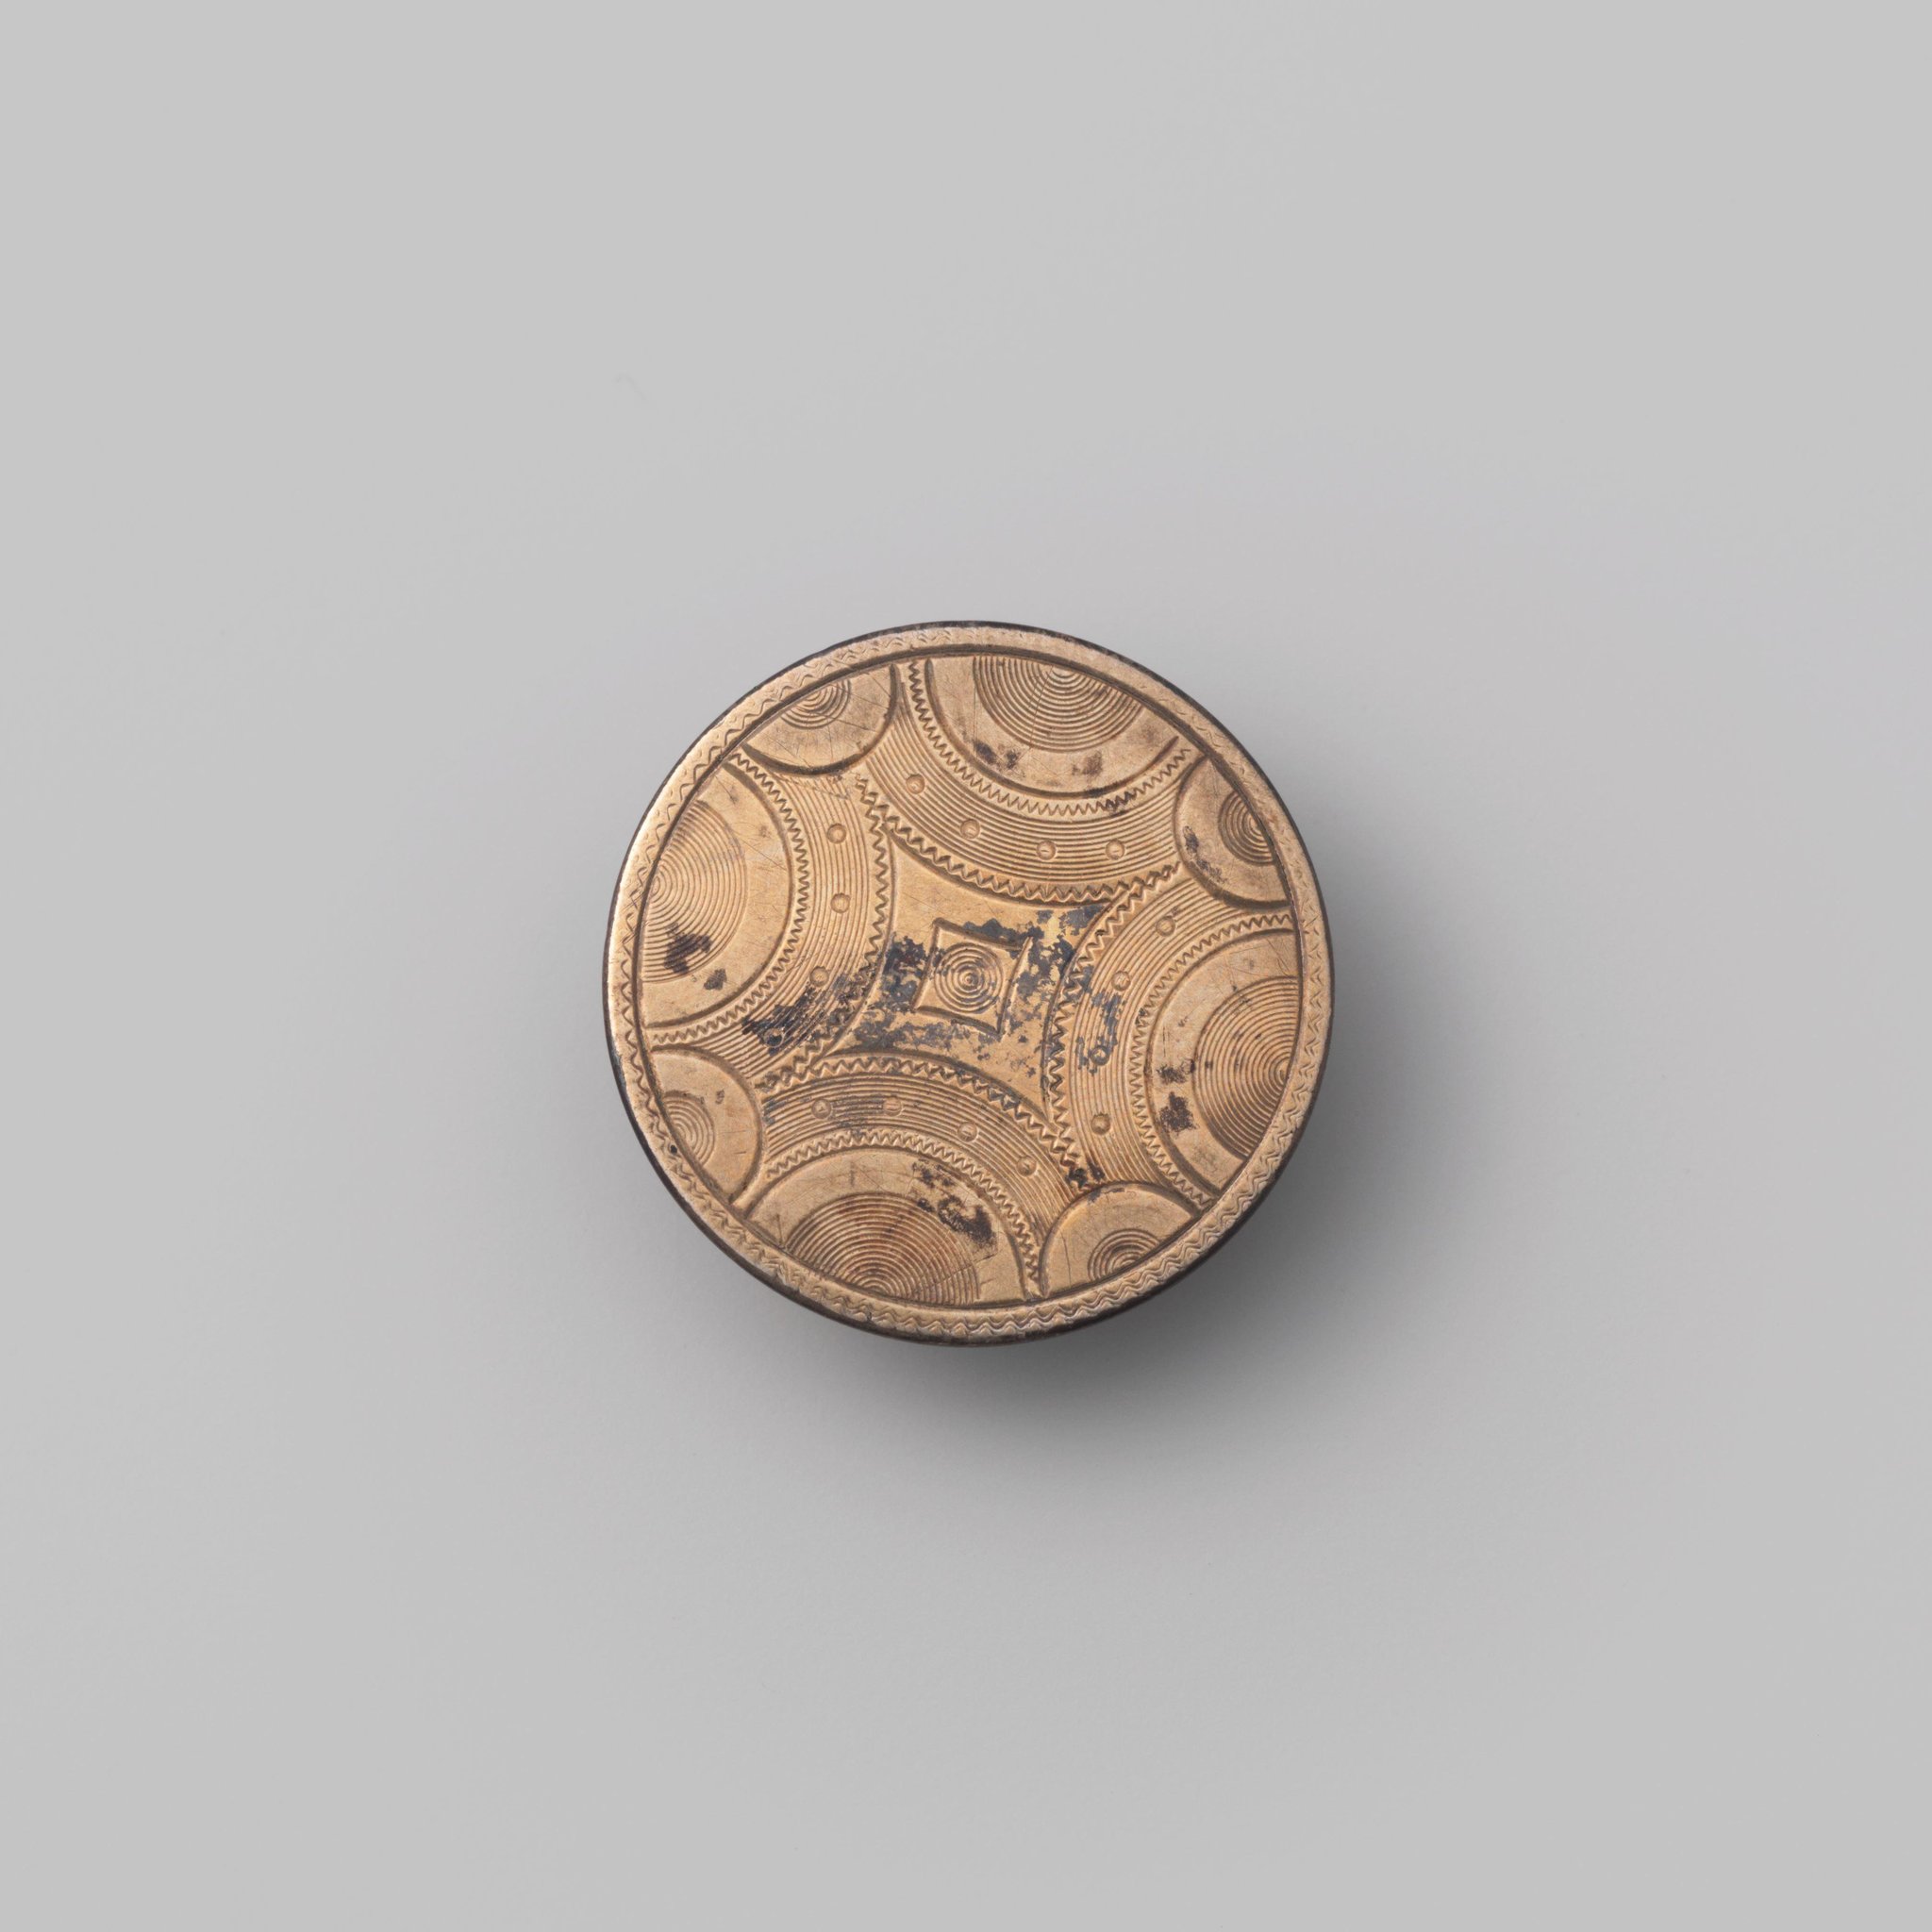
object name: cuff link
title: Platte ronde manchetknoop van verguld zilver, versierd met guilloches met een ruitje met holle zijden en acht concentrische gladde cirkelbogen daaromheen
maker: Anonymous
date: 1850-1900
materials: silver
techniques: engraving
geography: netherlands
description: Platte ronde manchetknoop van verguld zilver, versierd met guilloches met een ruitje met holle zijden en acht concentrische gladde cirkelbogen daaromheen. Onleesbare merkjes; doorgeslagen.